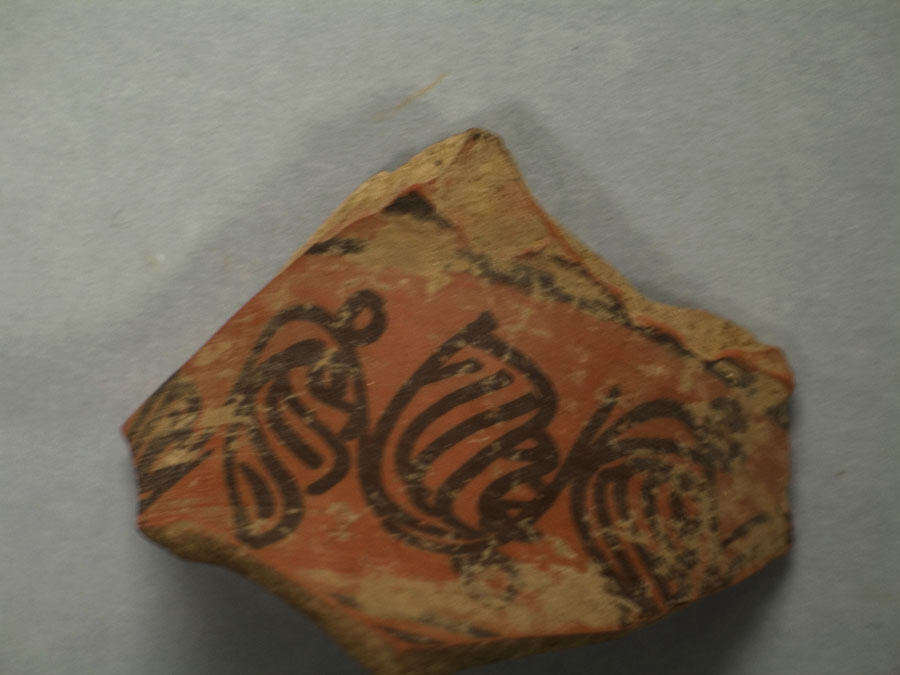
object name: shard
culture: pakistani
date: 301-500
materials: terracotta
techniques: painting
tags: gandhara